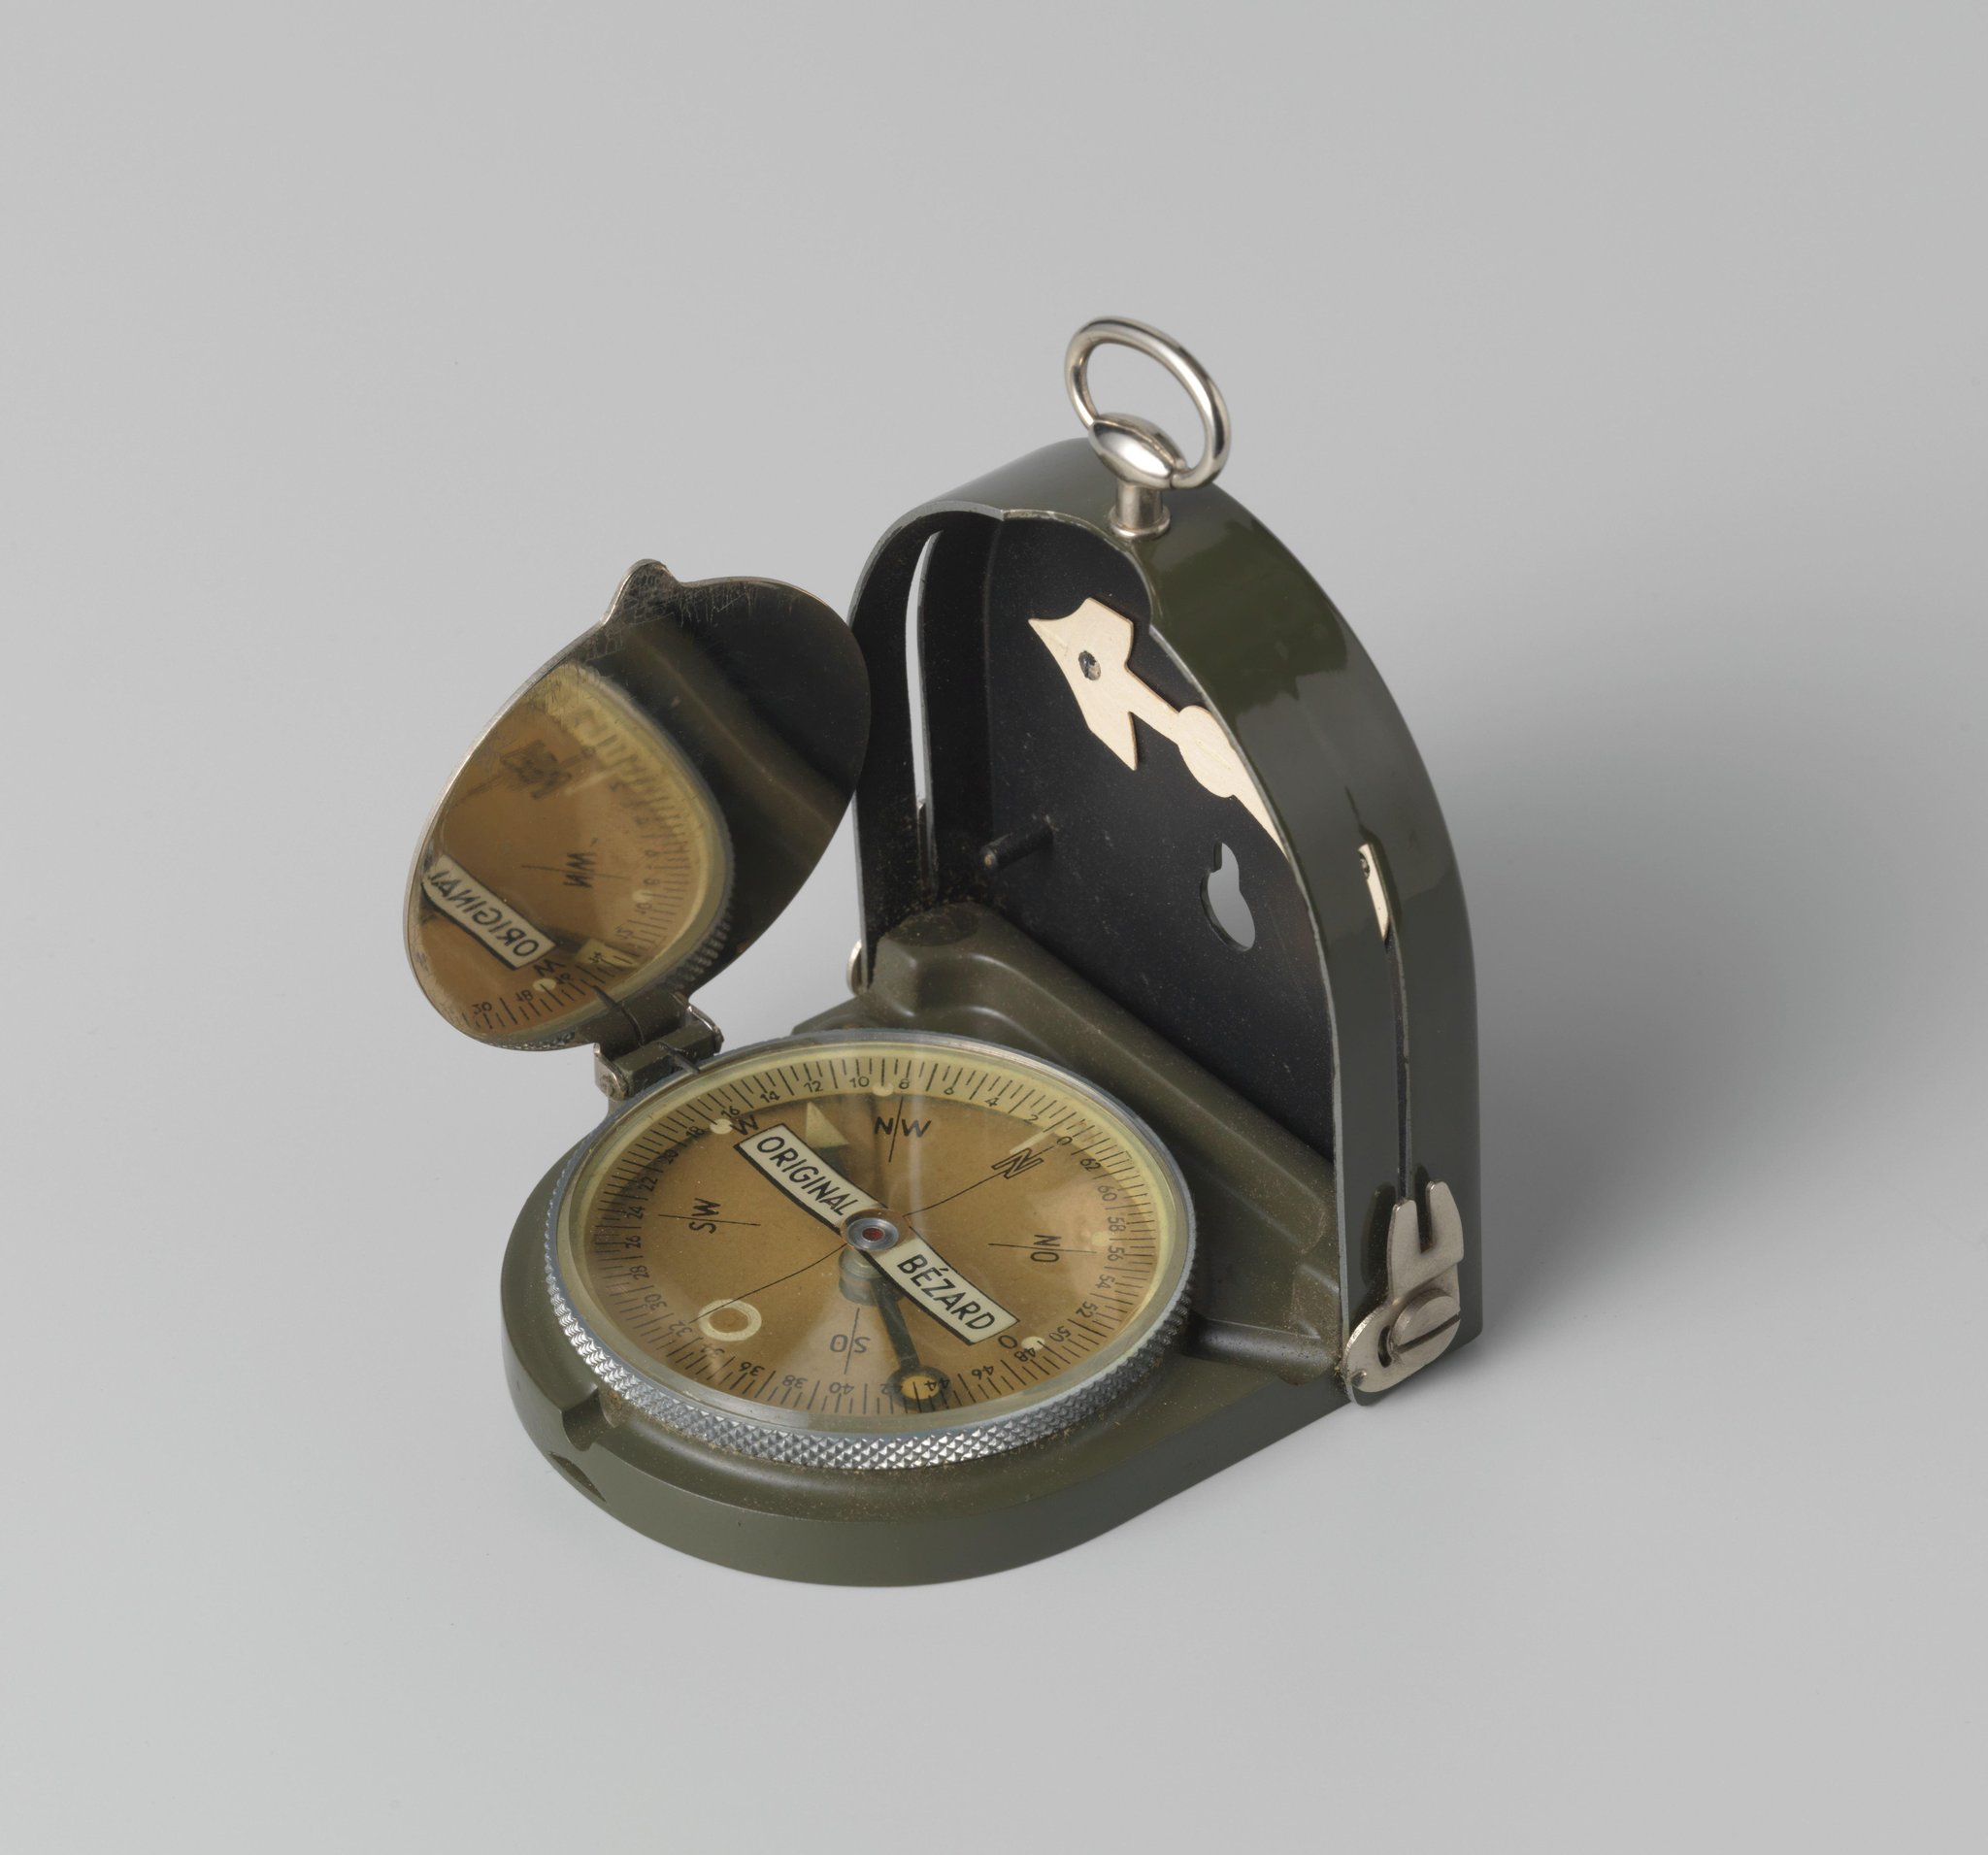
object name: compass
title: Kompas van een Duitse soldaat E.L. Koch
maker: johann ritter von bézard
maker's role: officier, professor, uitvinder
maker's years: 1871-1954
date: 1900-1950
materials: metal, plastic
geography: france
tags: e.l. koch, tweede wereldoorlog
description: Legergroen doosje, halfrond met rechte onderzijde. Zilverkleurig ophangoog aan de bovenkant. Aan de rechterkant verdeling in centimeters.